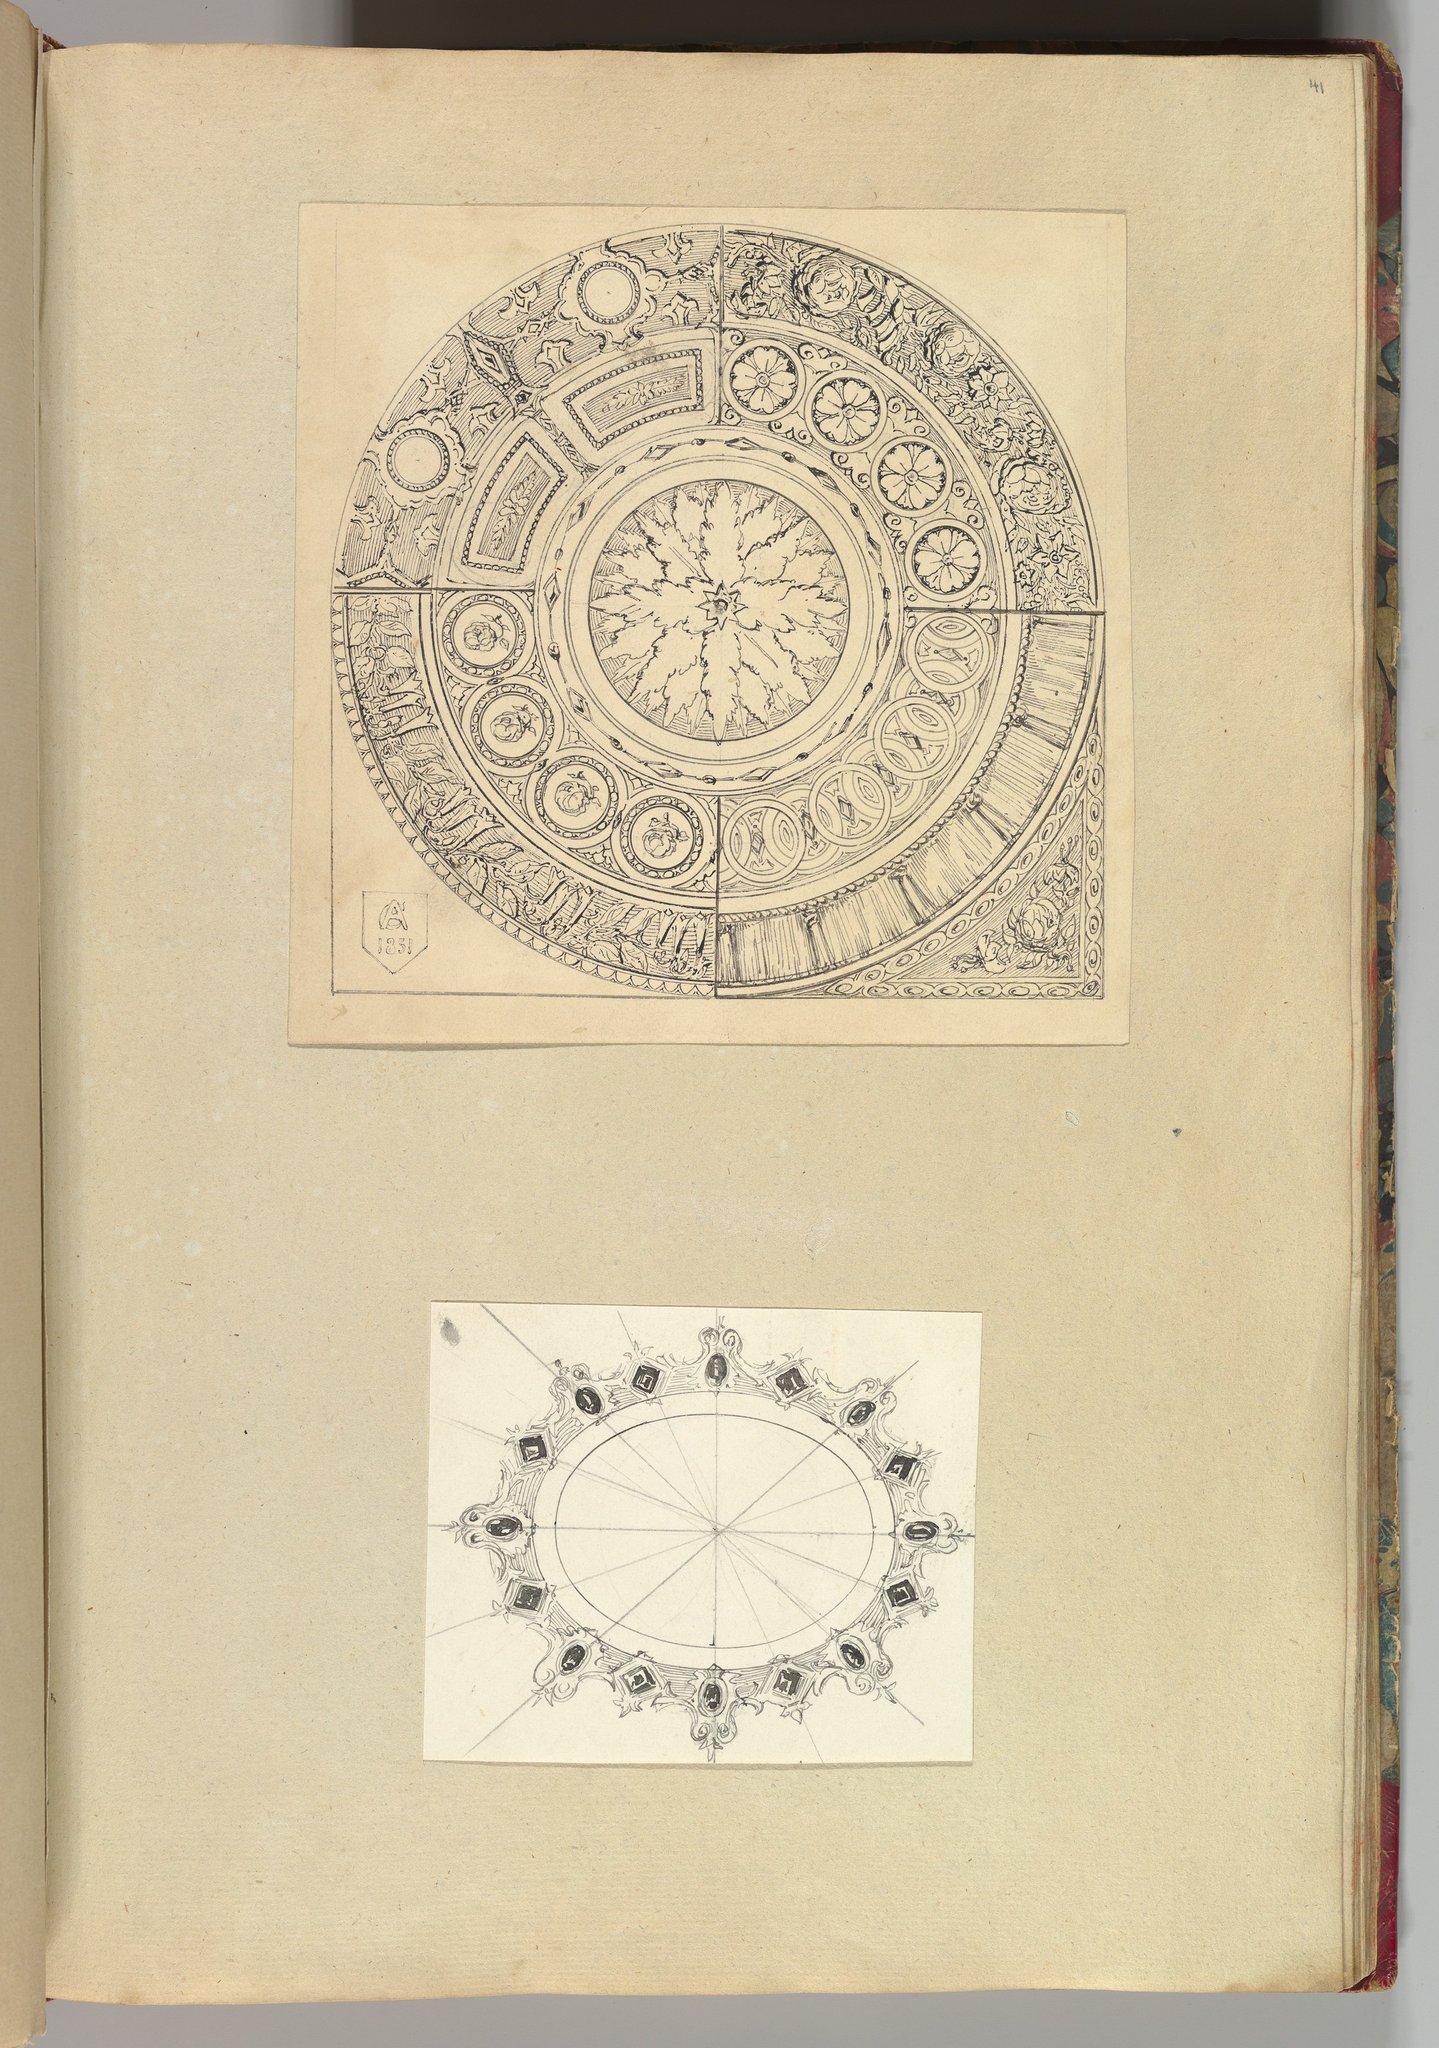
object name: drawing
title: Designs for a Panel of Ornament and a Brooch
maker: alfred henry forrester [alfred crowquill]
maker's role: artist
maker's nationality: british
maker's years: 1804-1872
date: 1851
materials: ink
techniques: pen